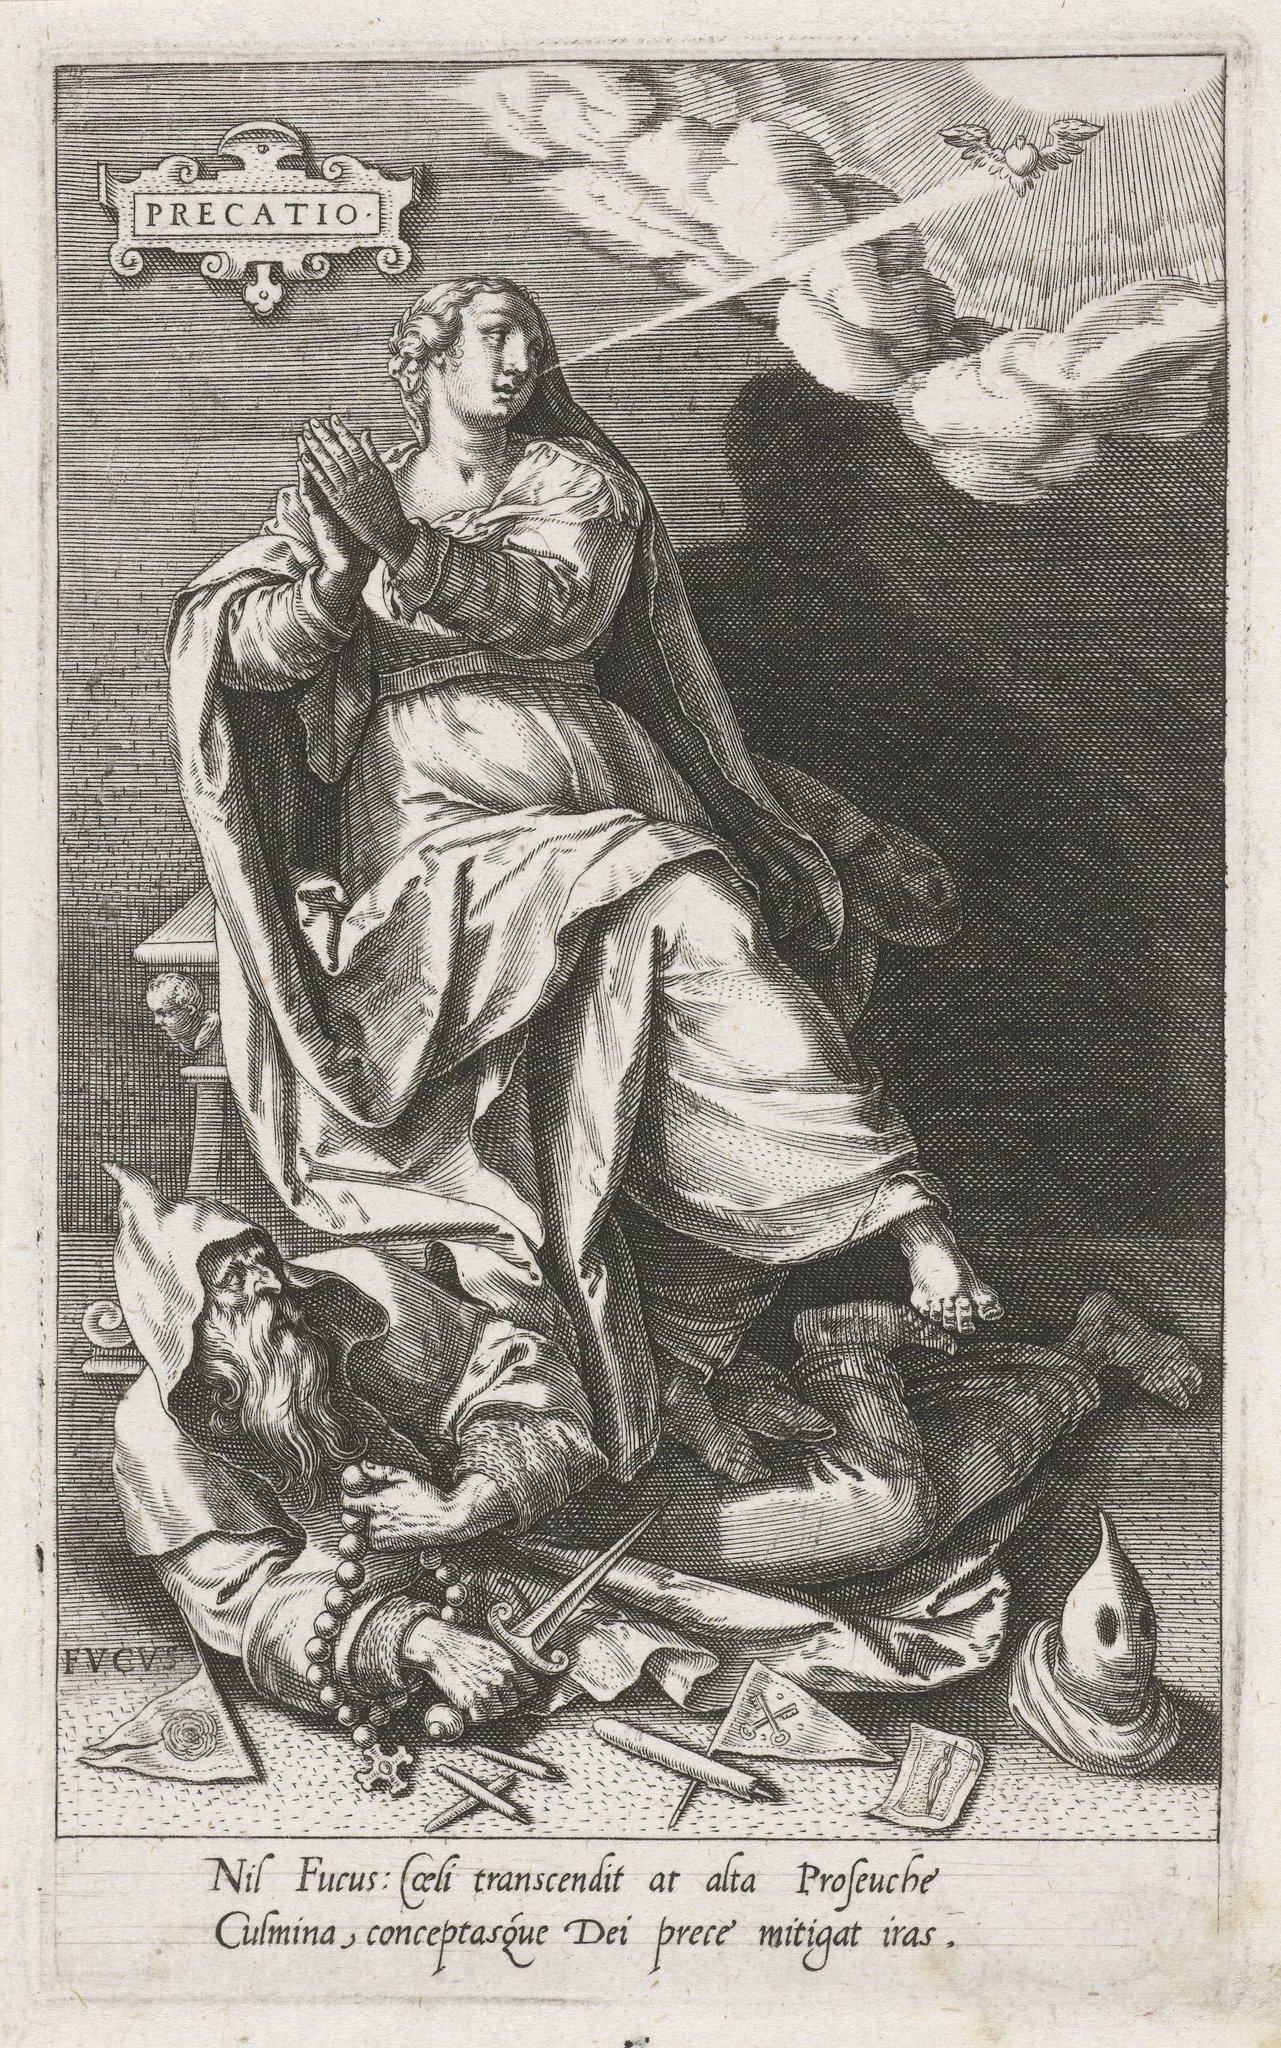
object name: print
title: Precatio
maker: johann sadeler (i)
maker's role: print maker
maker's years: 1550-1600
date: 1579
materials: paper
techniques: engraving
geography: antwerp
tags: false church personified, (private) prayer; 'oratione', 'preghiere', 'preghiere a dio' (ripa) (+ holy ghost (as a dove)), aids for prayer, e.g. rosary, monk(s), friar(s), candle, dissimulation, hypocrisy; 'hippocresia', 'simulatione' (ripa)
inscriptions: collector's mark: Lugt 240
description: De personificatie Gebed (Precatio), met haar handen gevouwen. Ze kijkt naar de verschijning van de Heilige Geest als duif in de rechterbovenhoek. Gebed vertrapt de personificatie van Schijnheiligheid (Fucus), een monnik met een rozenkrans en een dolk. Rondom hem liggen attributen van de Rooms-Katholieke Kerk.